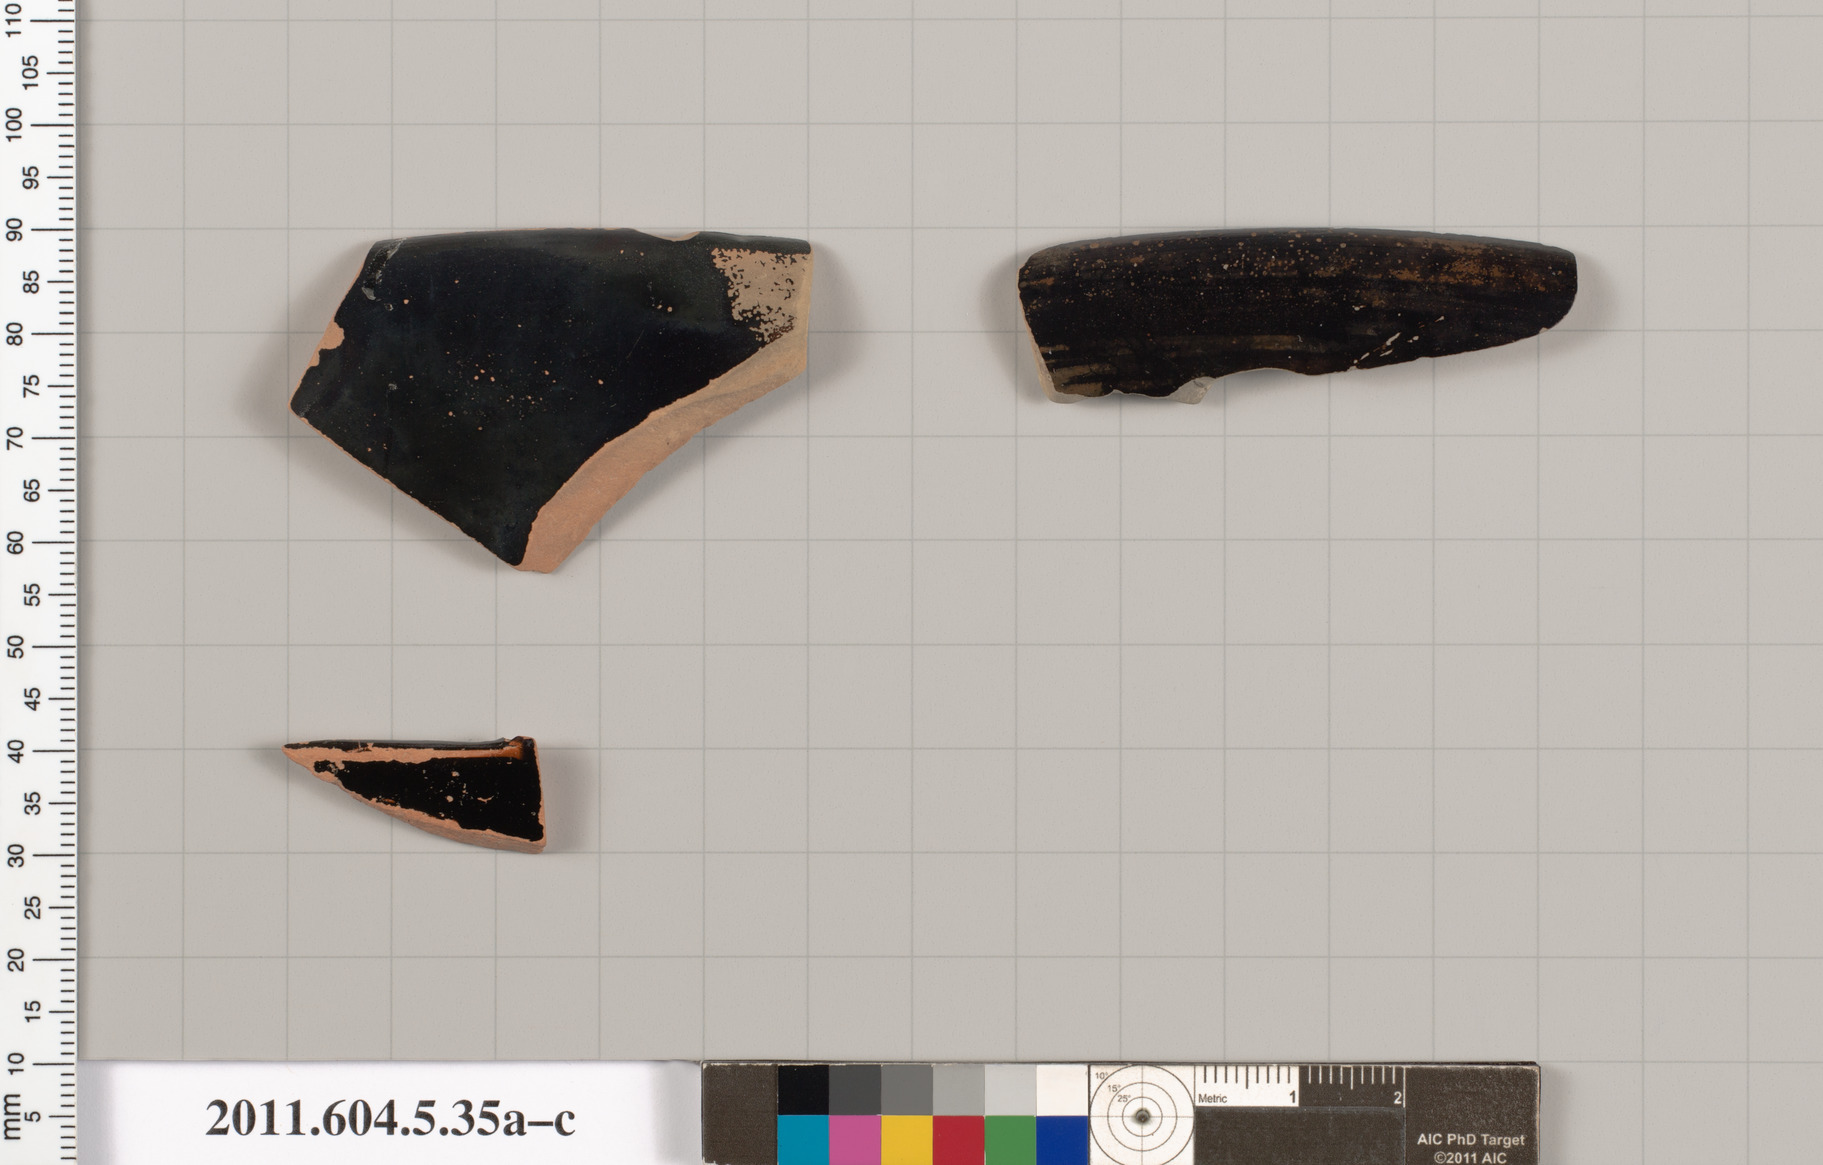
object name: kylix fragment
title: Terracotta rim fragments of kylikes (drinking cups)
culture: greek, attic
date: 500-401 BCE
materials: terracotta